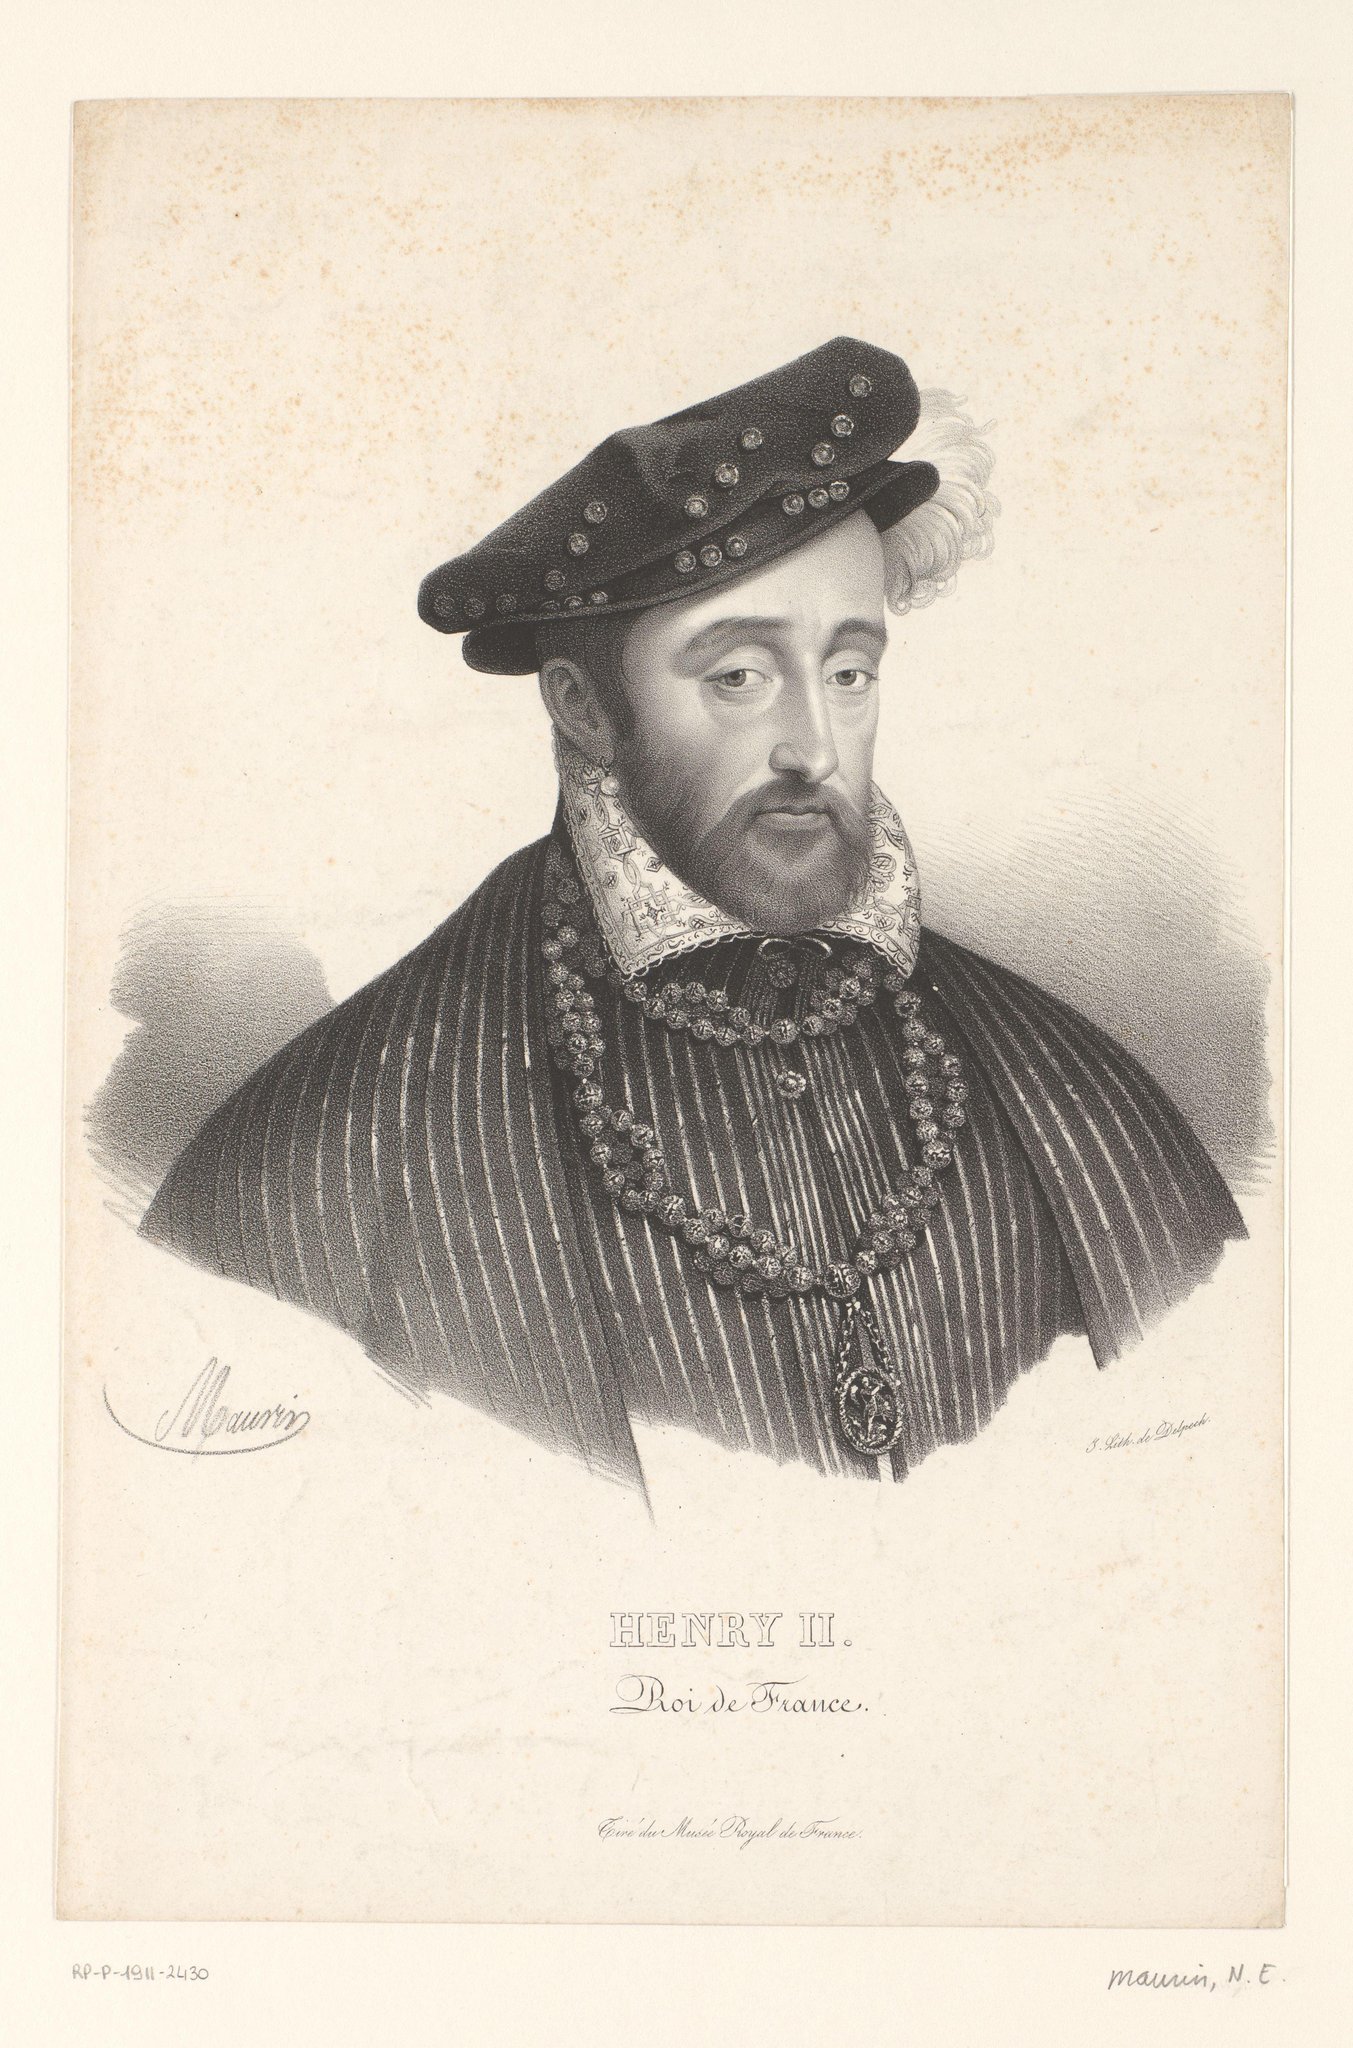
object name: print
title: Portret van Hendrik II, koning van Frankrijk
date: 1825-1842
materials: paper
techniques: lithograph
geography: paris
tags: paris, historical persons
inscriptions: collector's mark: Lugt 2228